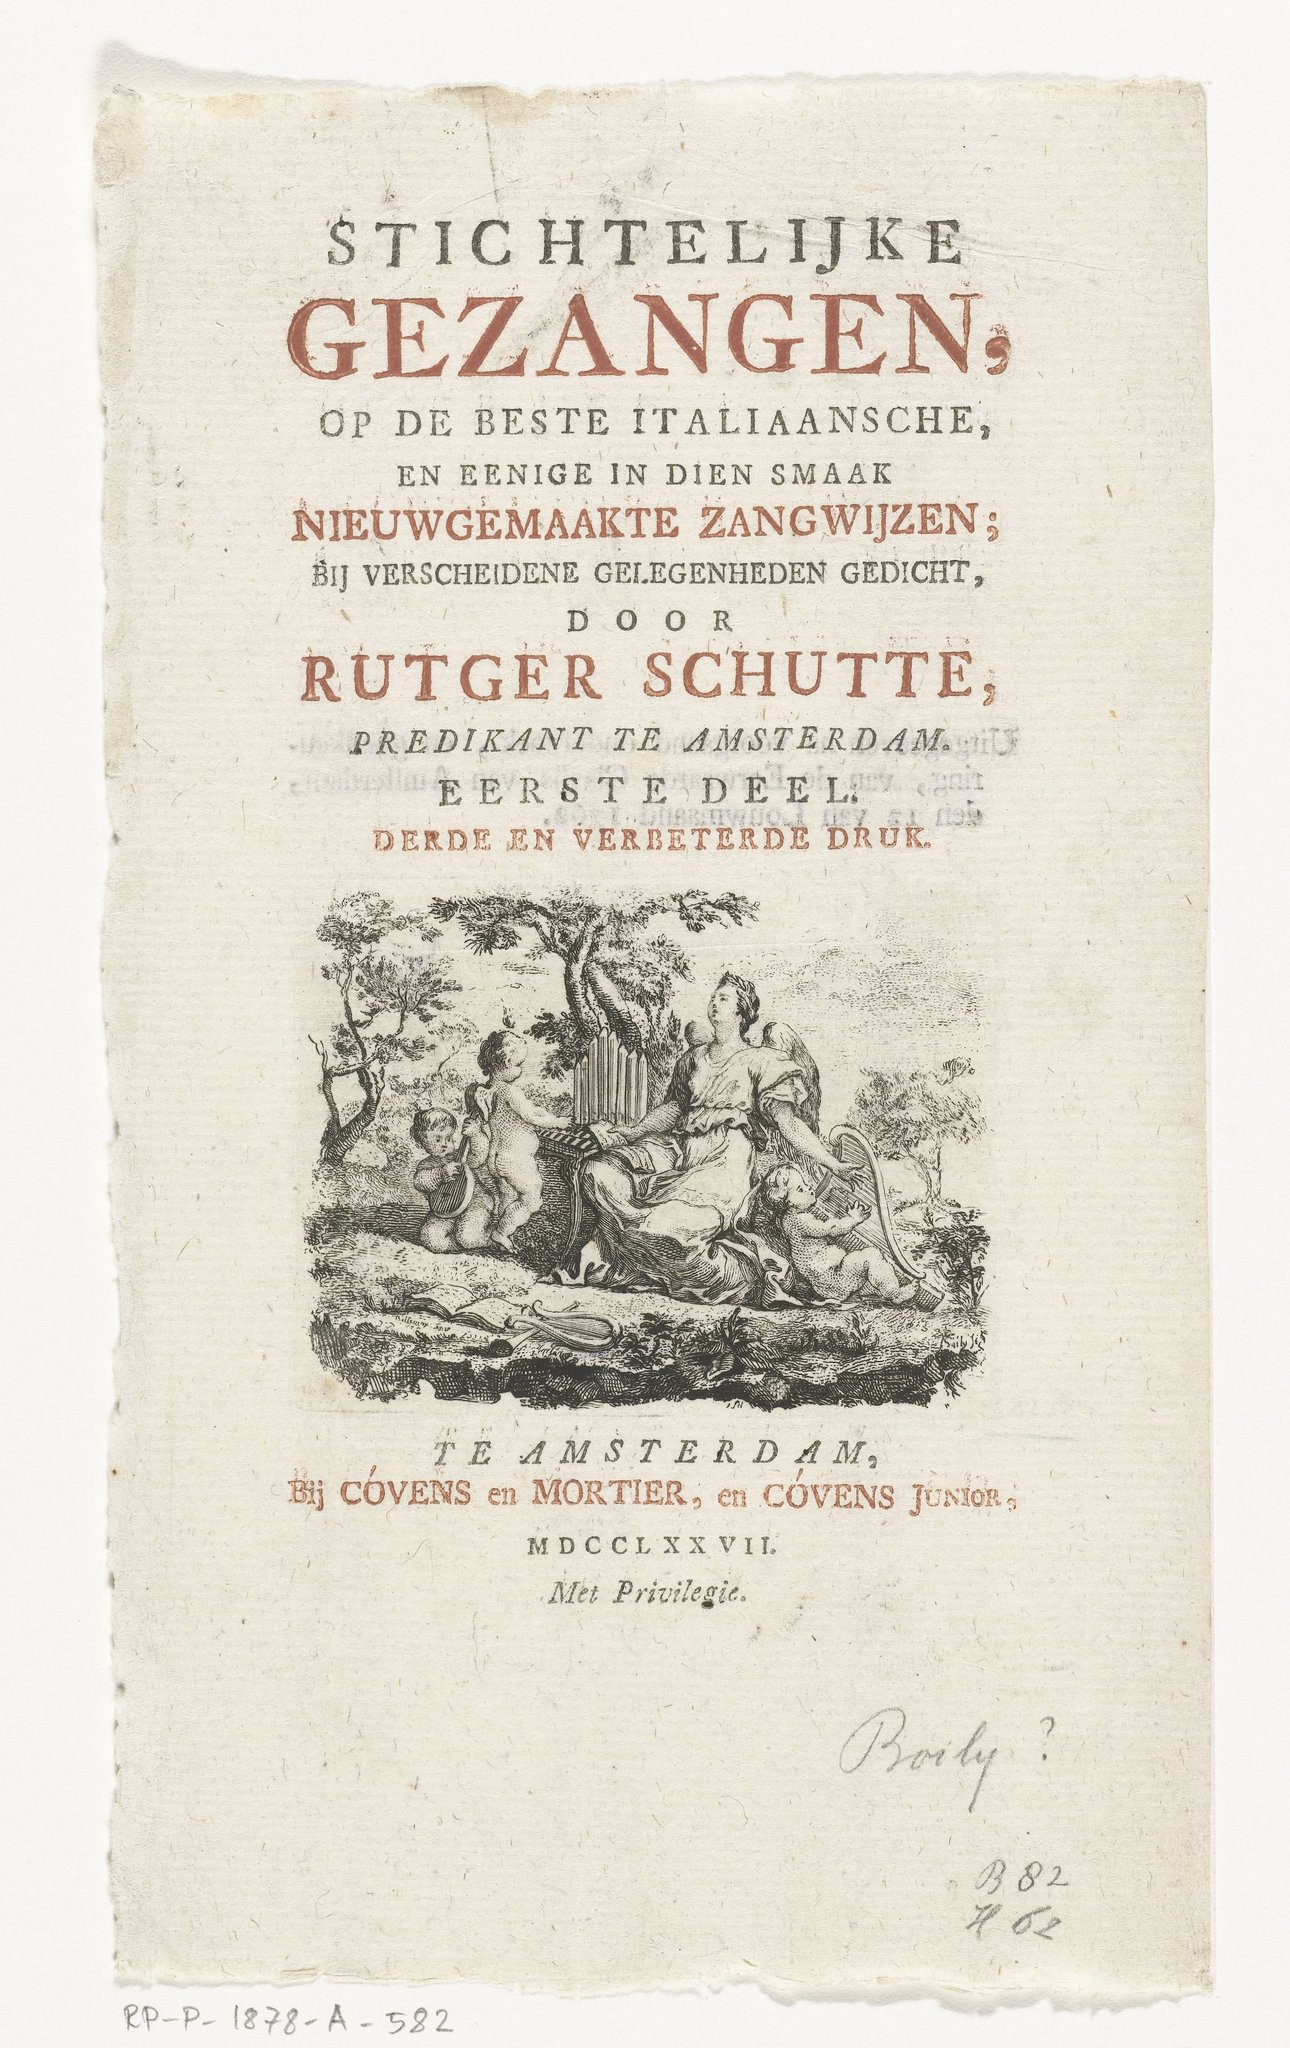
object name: titelblad, titelpagina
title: Titelpagina voor: R. Schutte, Stichtelijke gezangen, Amsterdam, 1777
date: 1777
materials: paper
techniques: etching, letterpress printing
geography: amsterdam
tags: angels singing, making music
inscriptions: date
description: Titelpagina voor: R. Schutte, Stichtelijke gezangen, Amsterdam, J. Covens en C. Mortier en J. Covens jr., 1777.